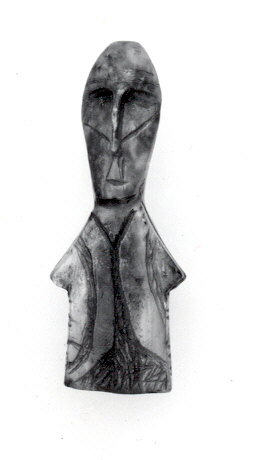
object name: figure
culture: punuk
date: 101-400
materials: ivory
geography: united states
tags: human figures